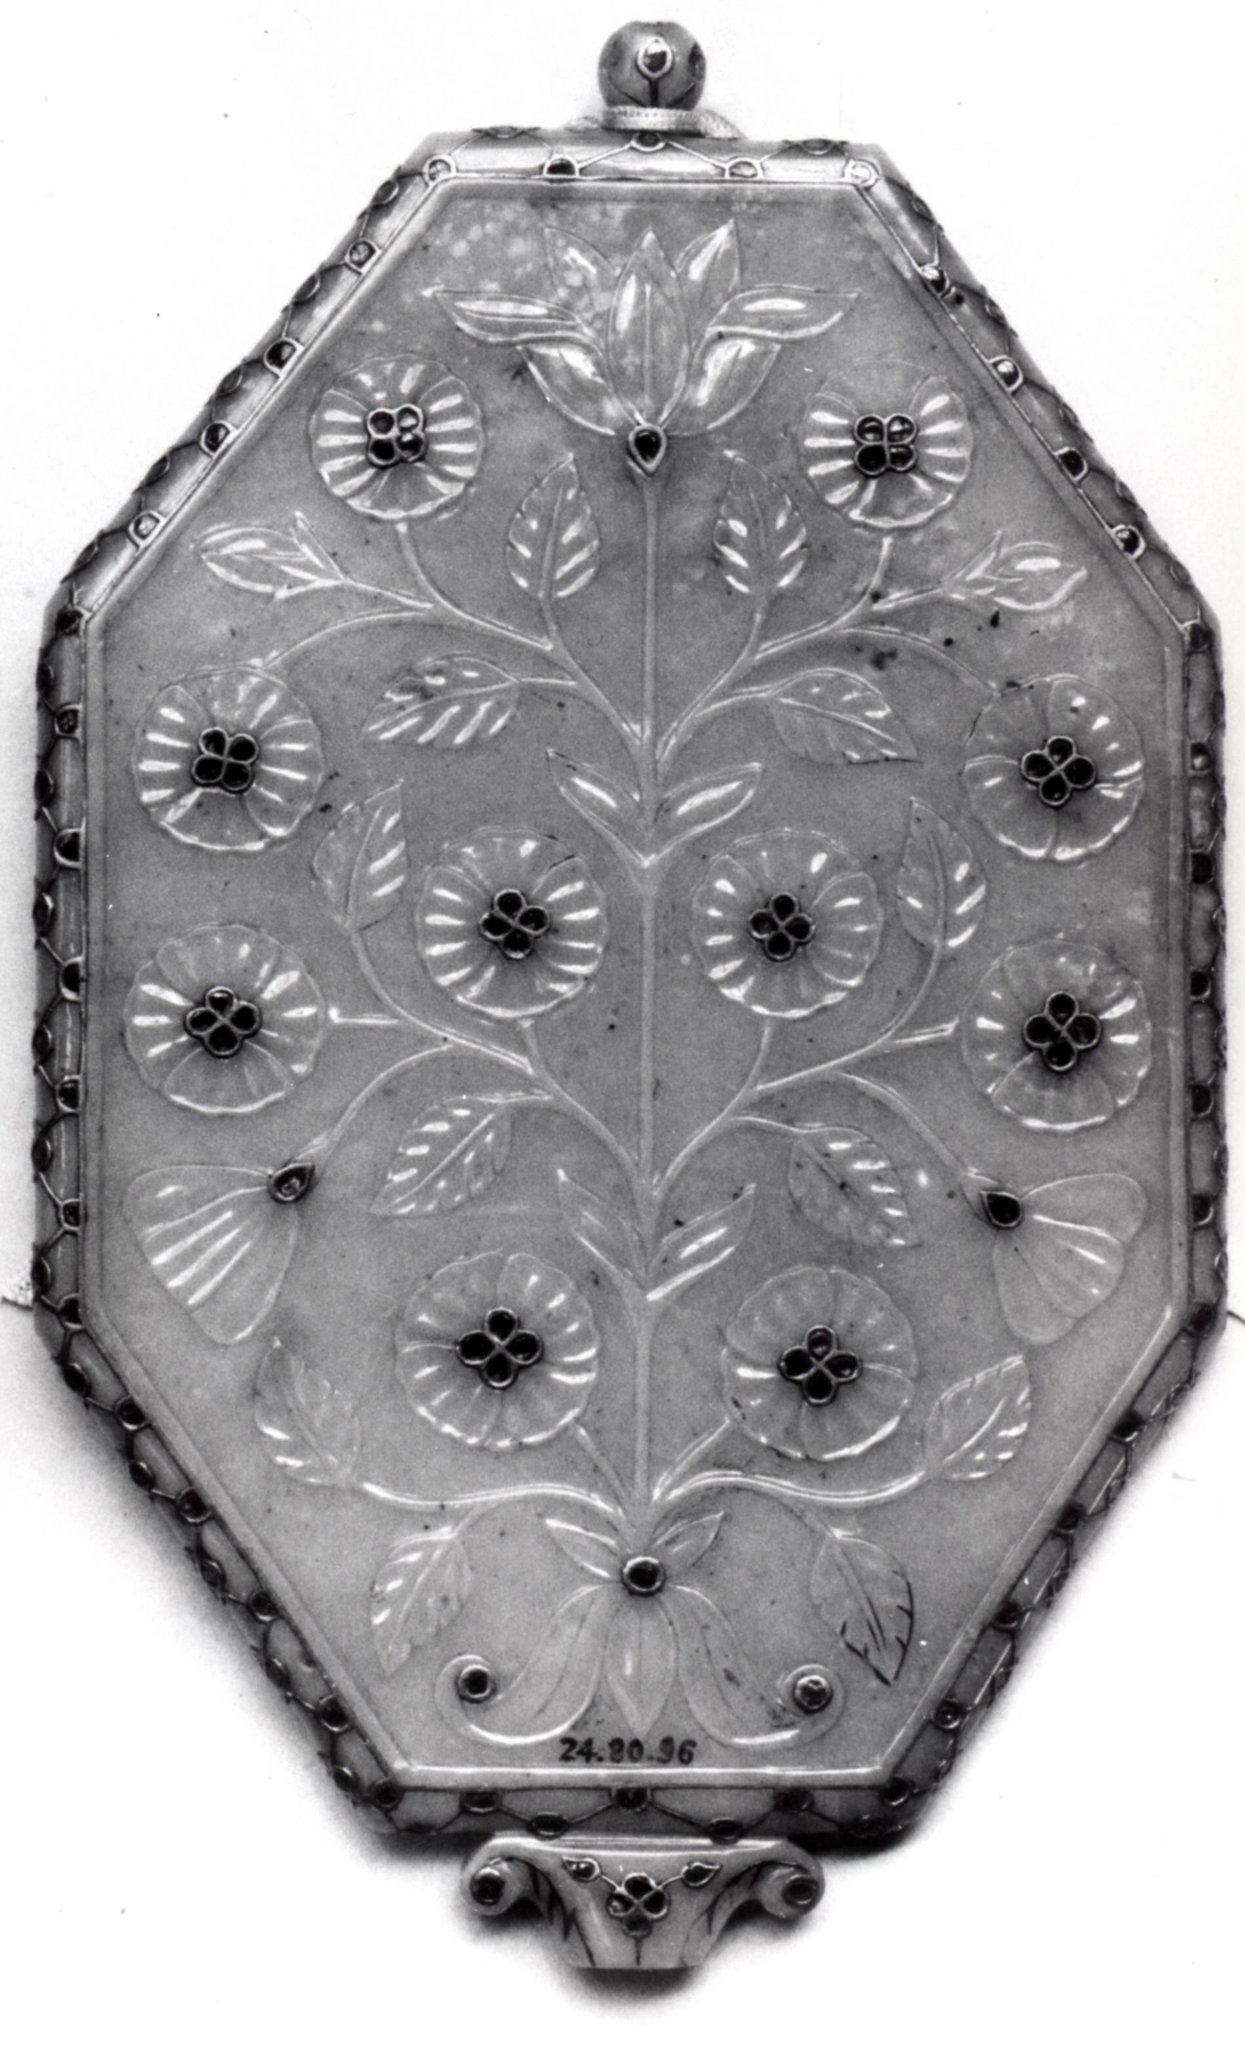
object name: mirror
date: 1701-1800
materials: jade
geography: india